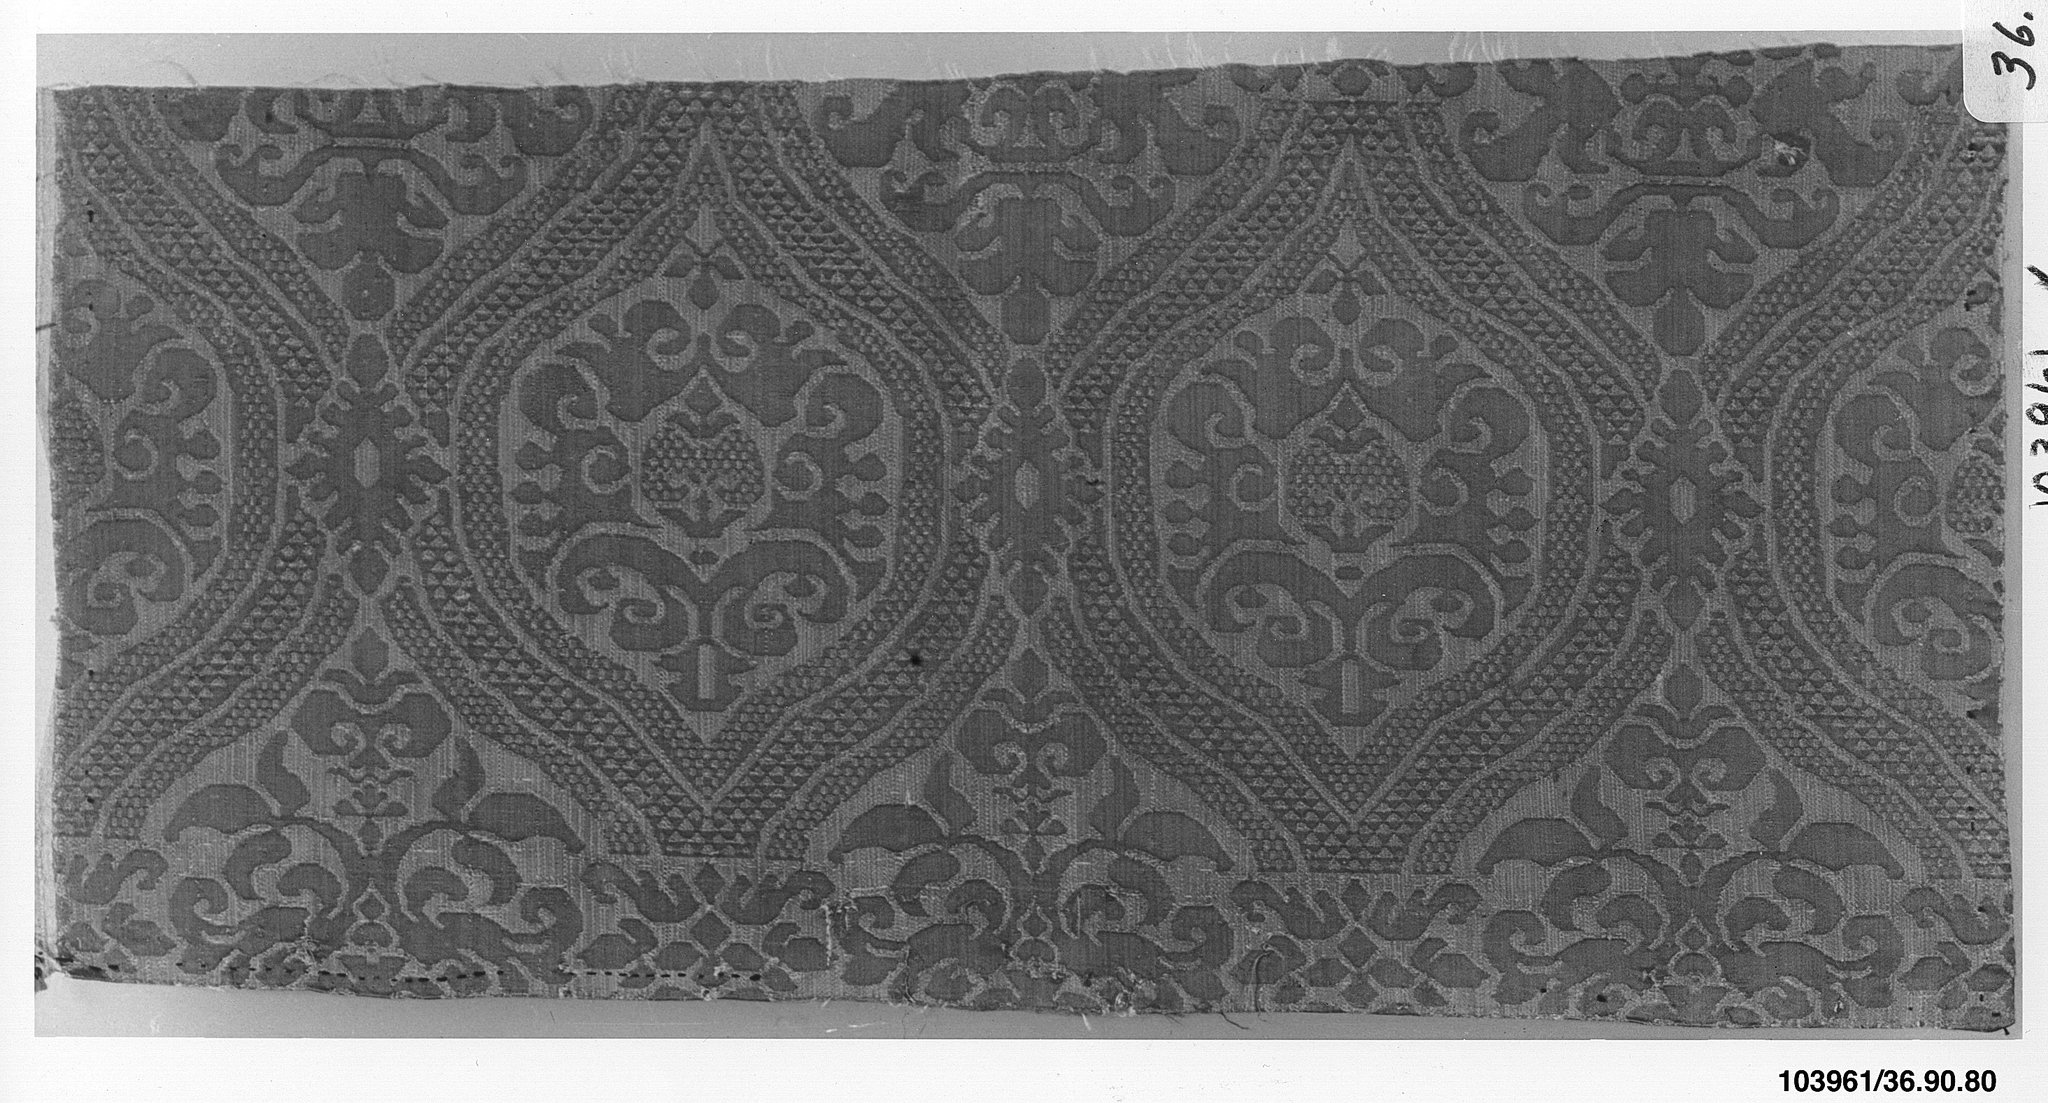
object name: piece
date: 1501-1600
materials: silk